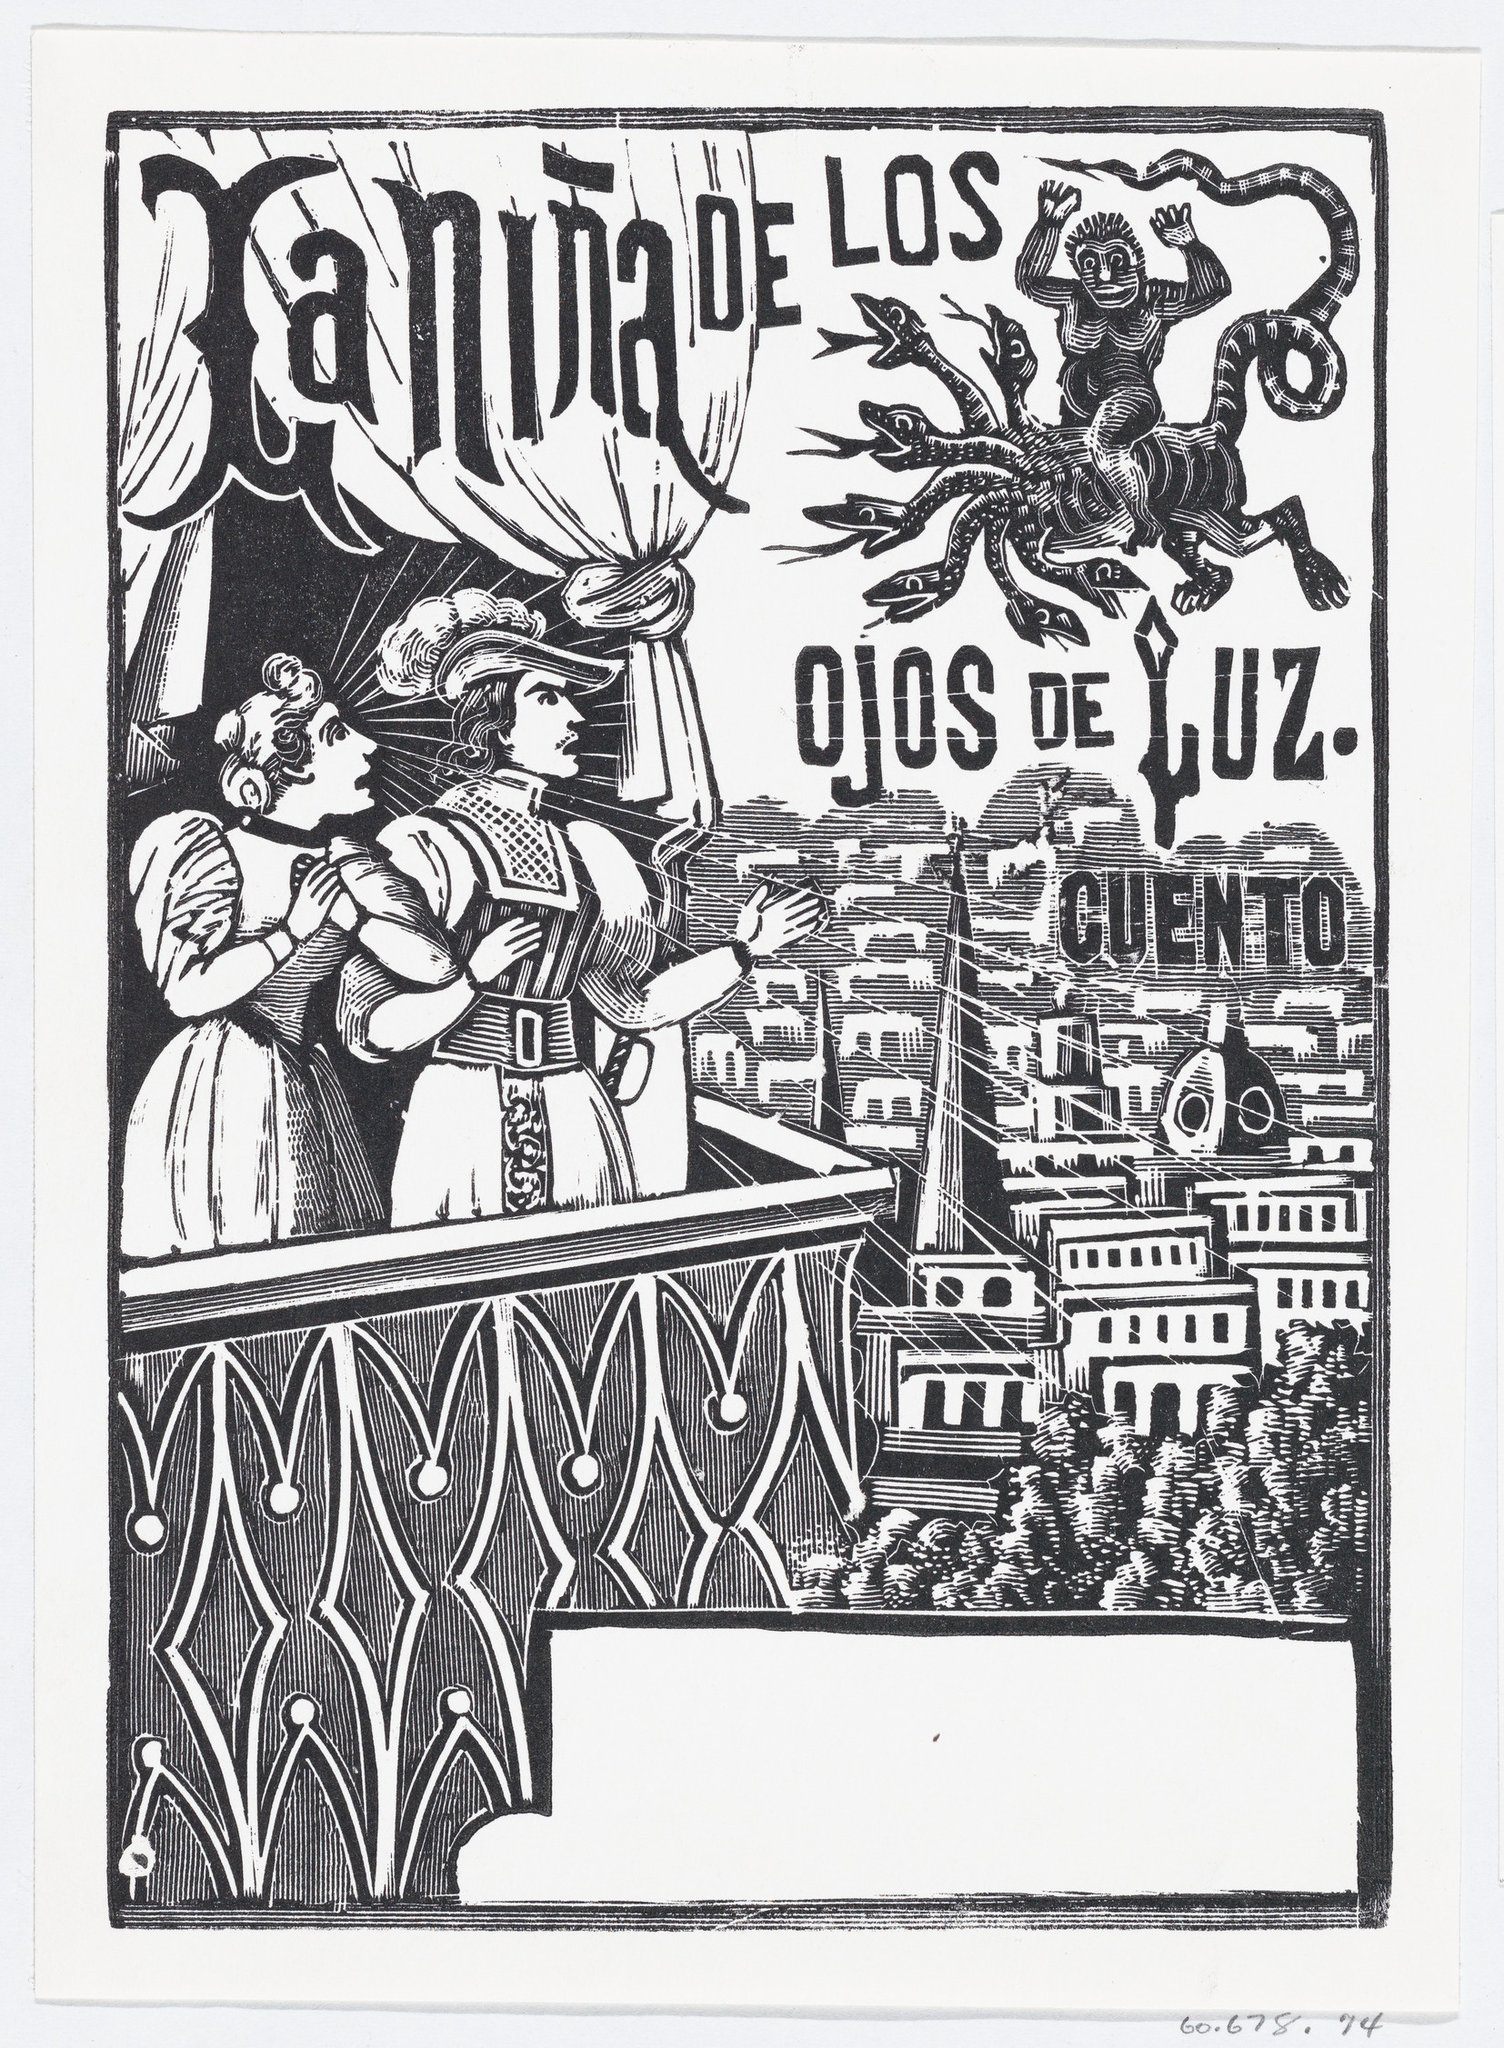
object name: print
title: A woman and a man standing on a balcony looking up at a flying monster in the sky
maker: josé guadalupe posada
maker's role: artist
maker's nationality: mexican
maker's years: 1852-1913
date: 1880-1910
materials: metal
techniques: engraving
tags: balconies,men,women,monsters